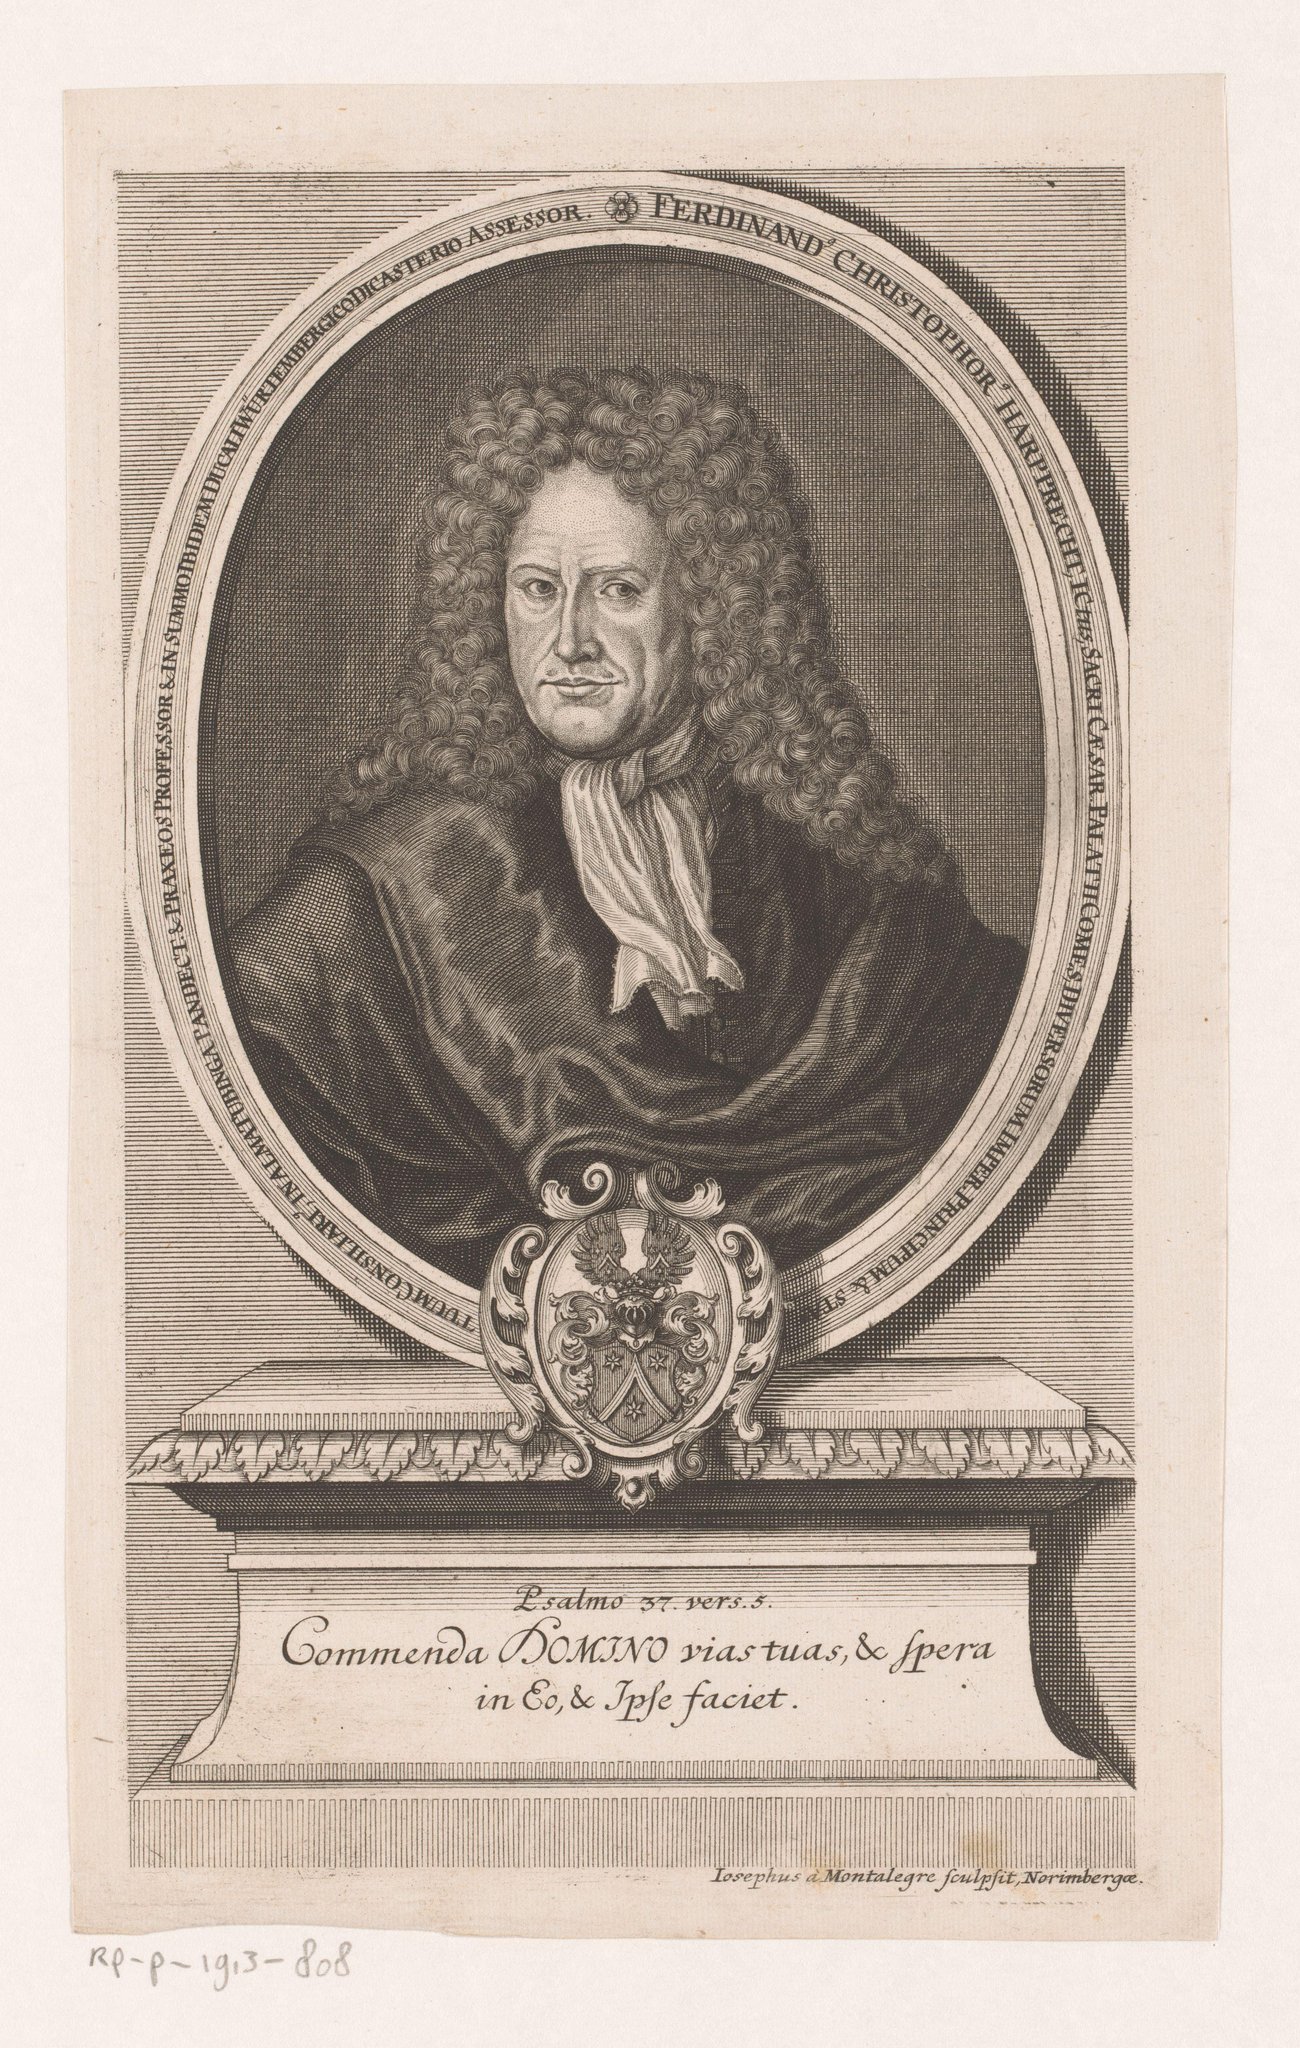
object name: print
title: Portret van Ferdinand Christoph Harpprecht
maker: joseph de montalegre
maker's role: print maker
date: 1700-1799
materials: paper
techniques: engraving, etching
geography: nuremberg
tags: historical persons, wig, armorial bearing, heraldry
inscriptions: collector's mark: Lugt 2228